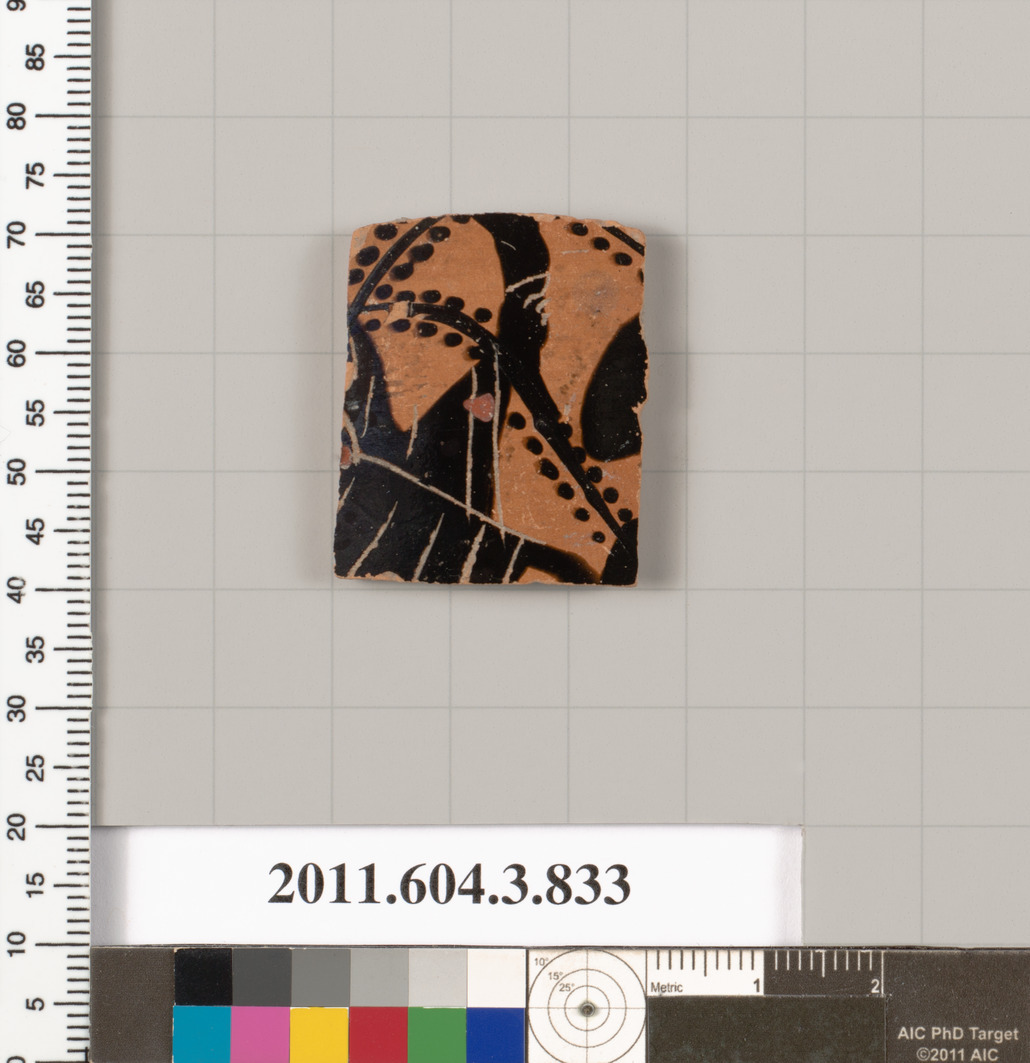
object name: lekythos fragment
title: Terracotta fragment of a lekythos (oil flask)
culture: greek, attic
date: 534-501 BCE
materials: terracotta